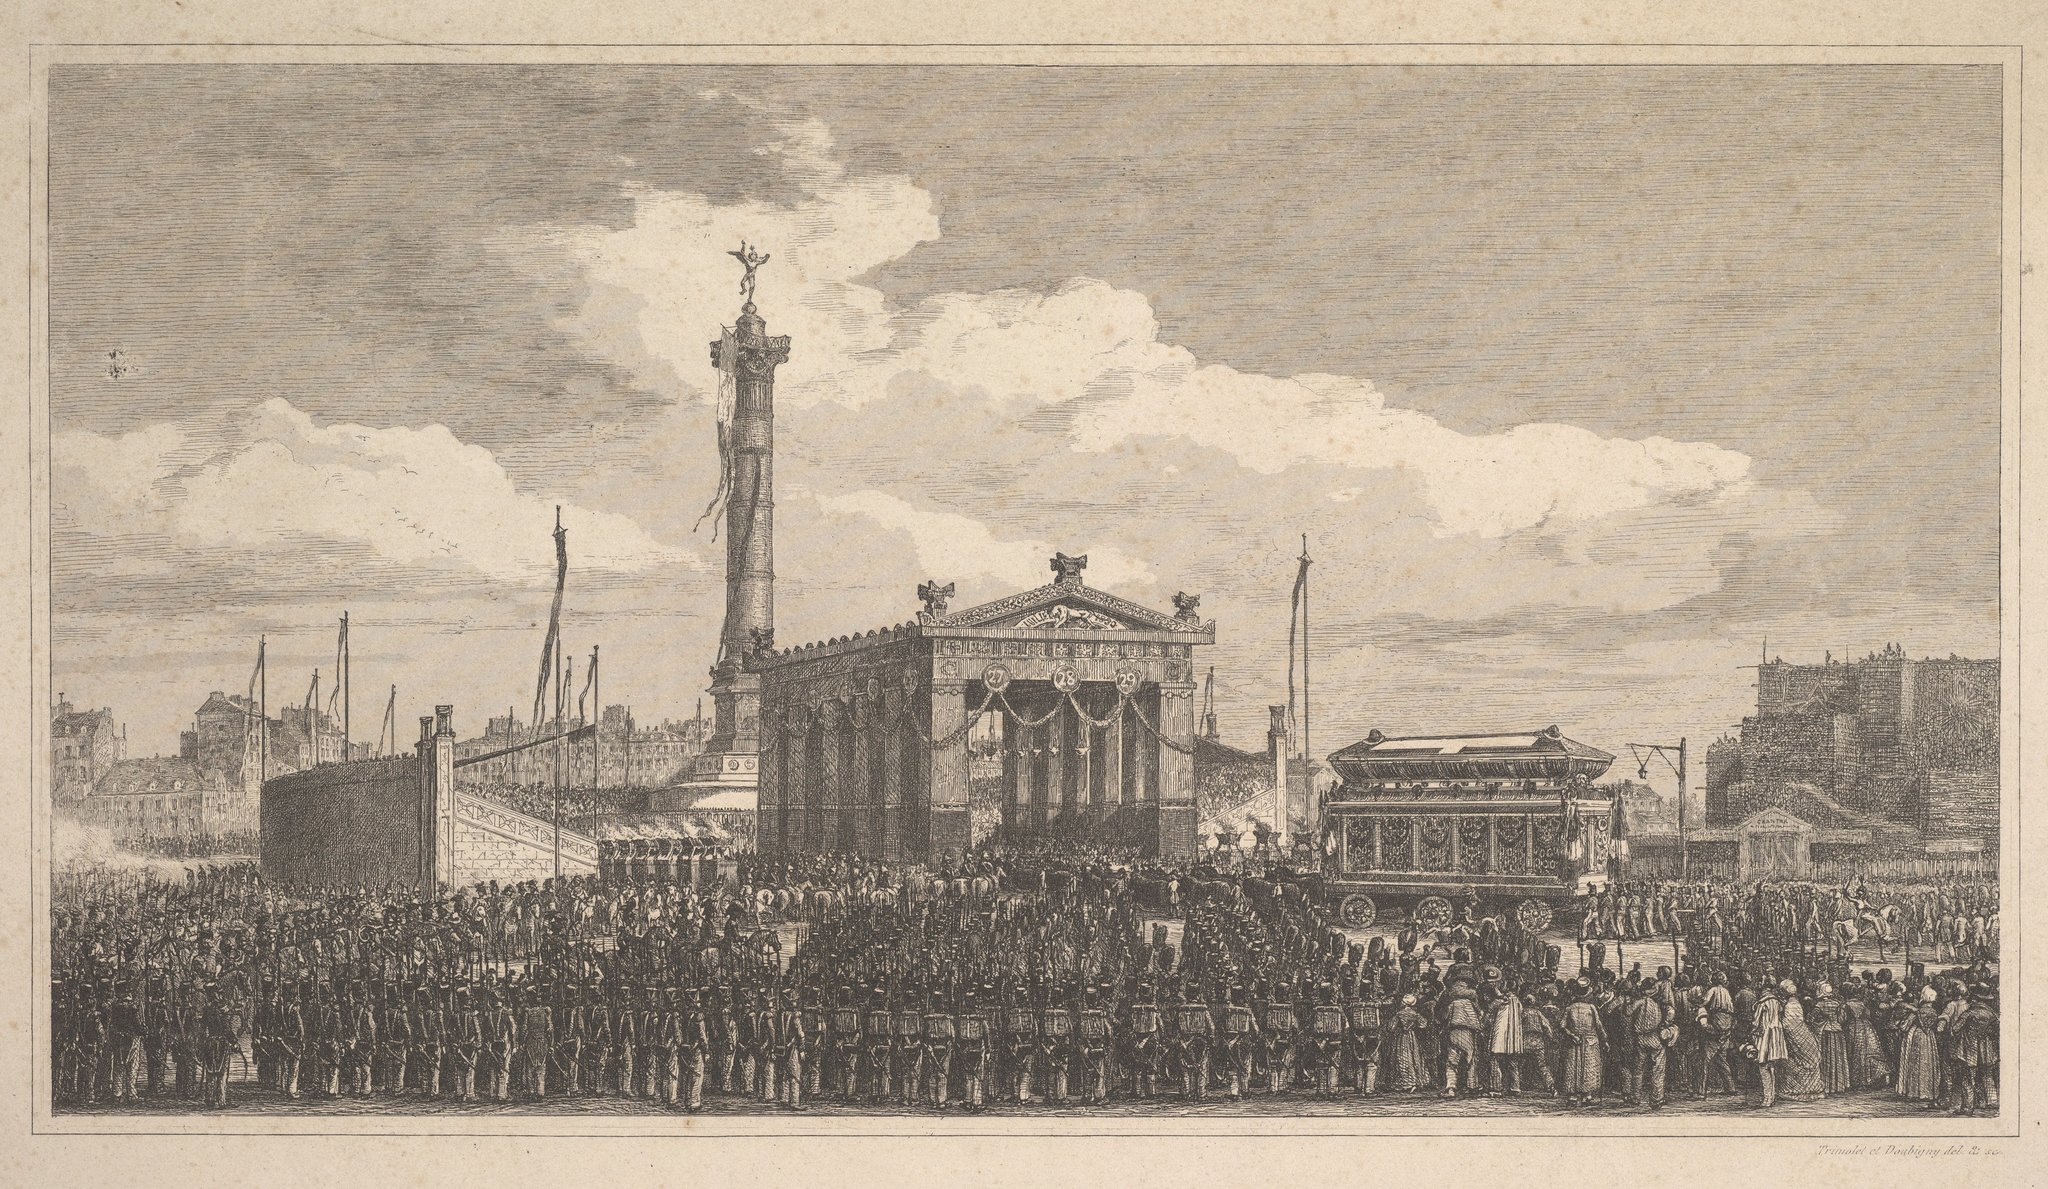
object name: print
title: Cérémonie de l'inauguration de la colonne de juillet, 1840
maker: charles-françois daubigny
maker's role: artist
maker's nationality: french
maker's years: 1817-1878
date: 1840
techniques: etching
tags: buildings,monuments,soldiers,crowd